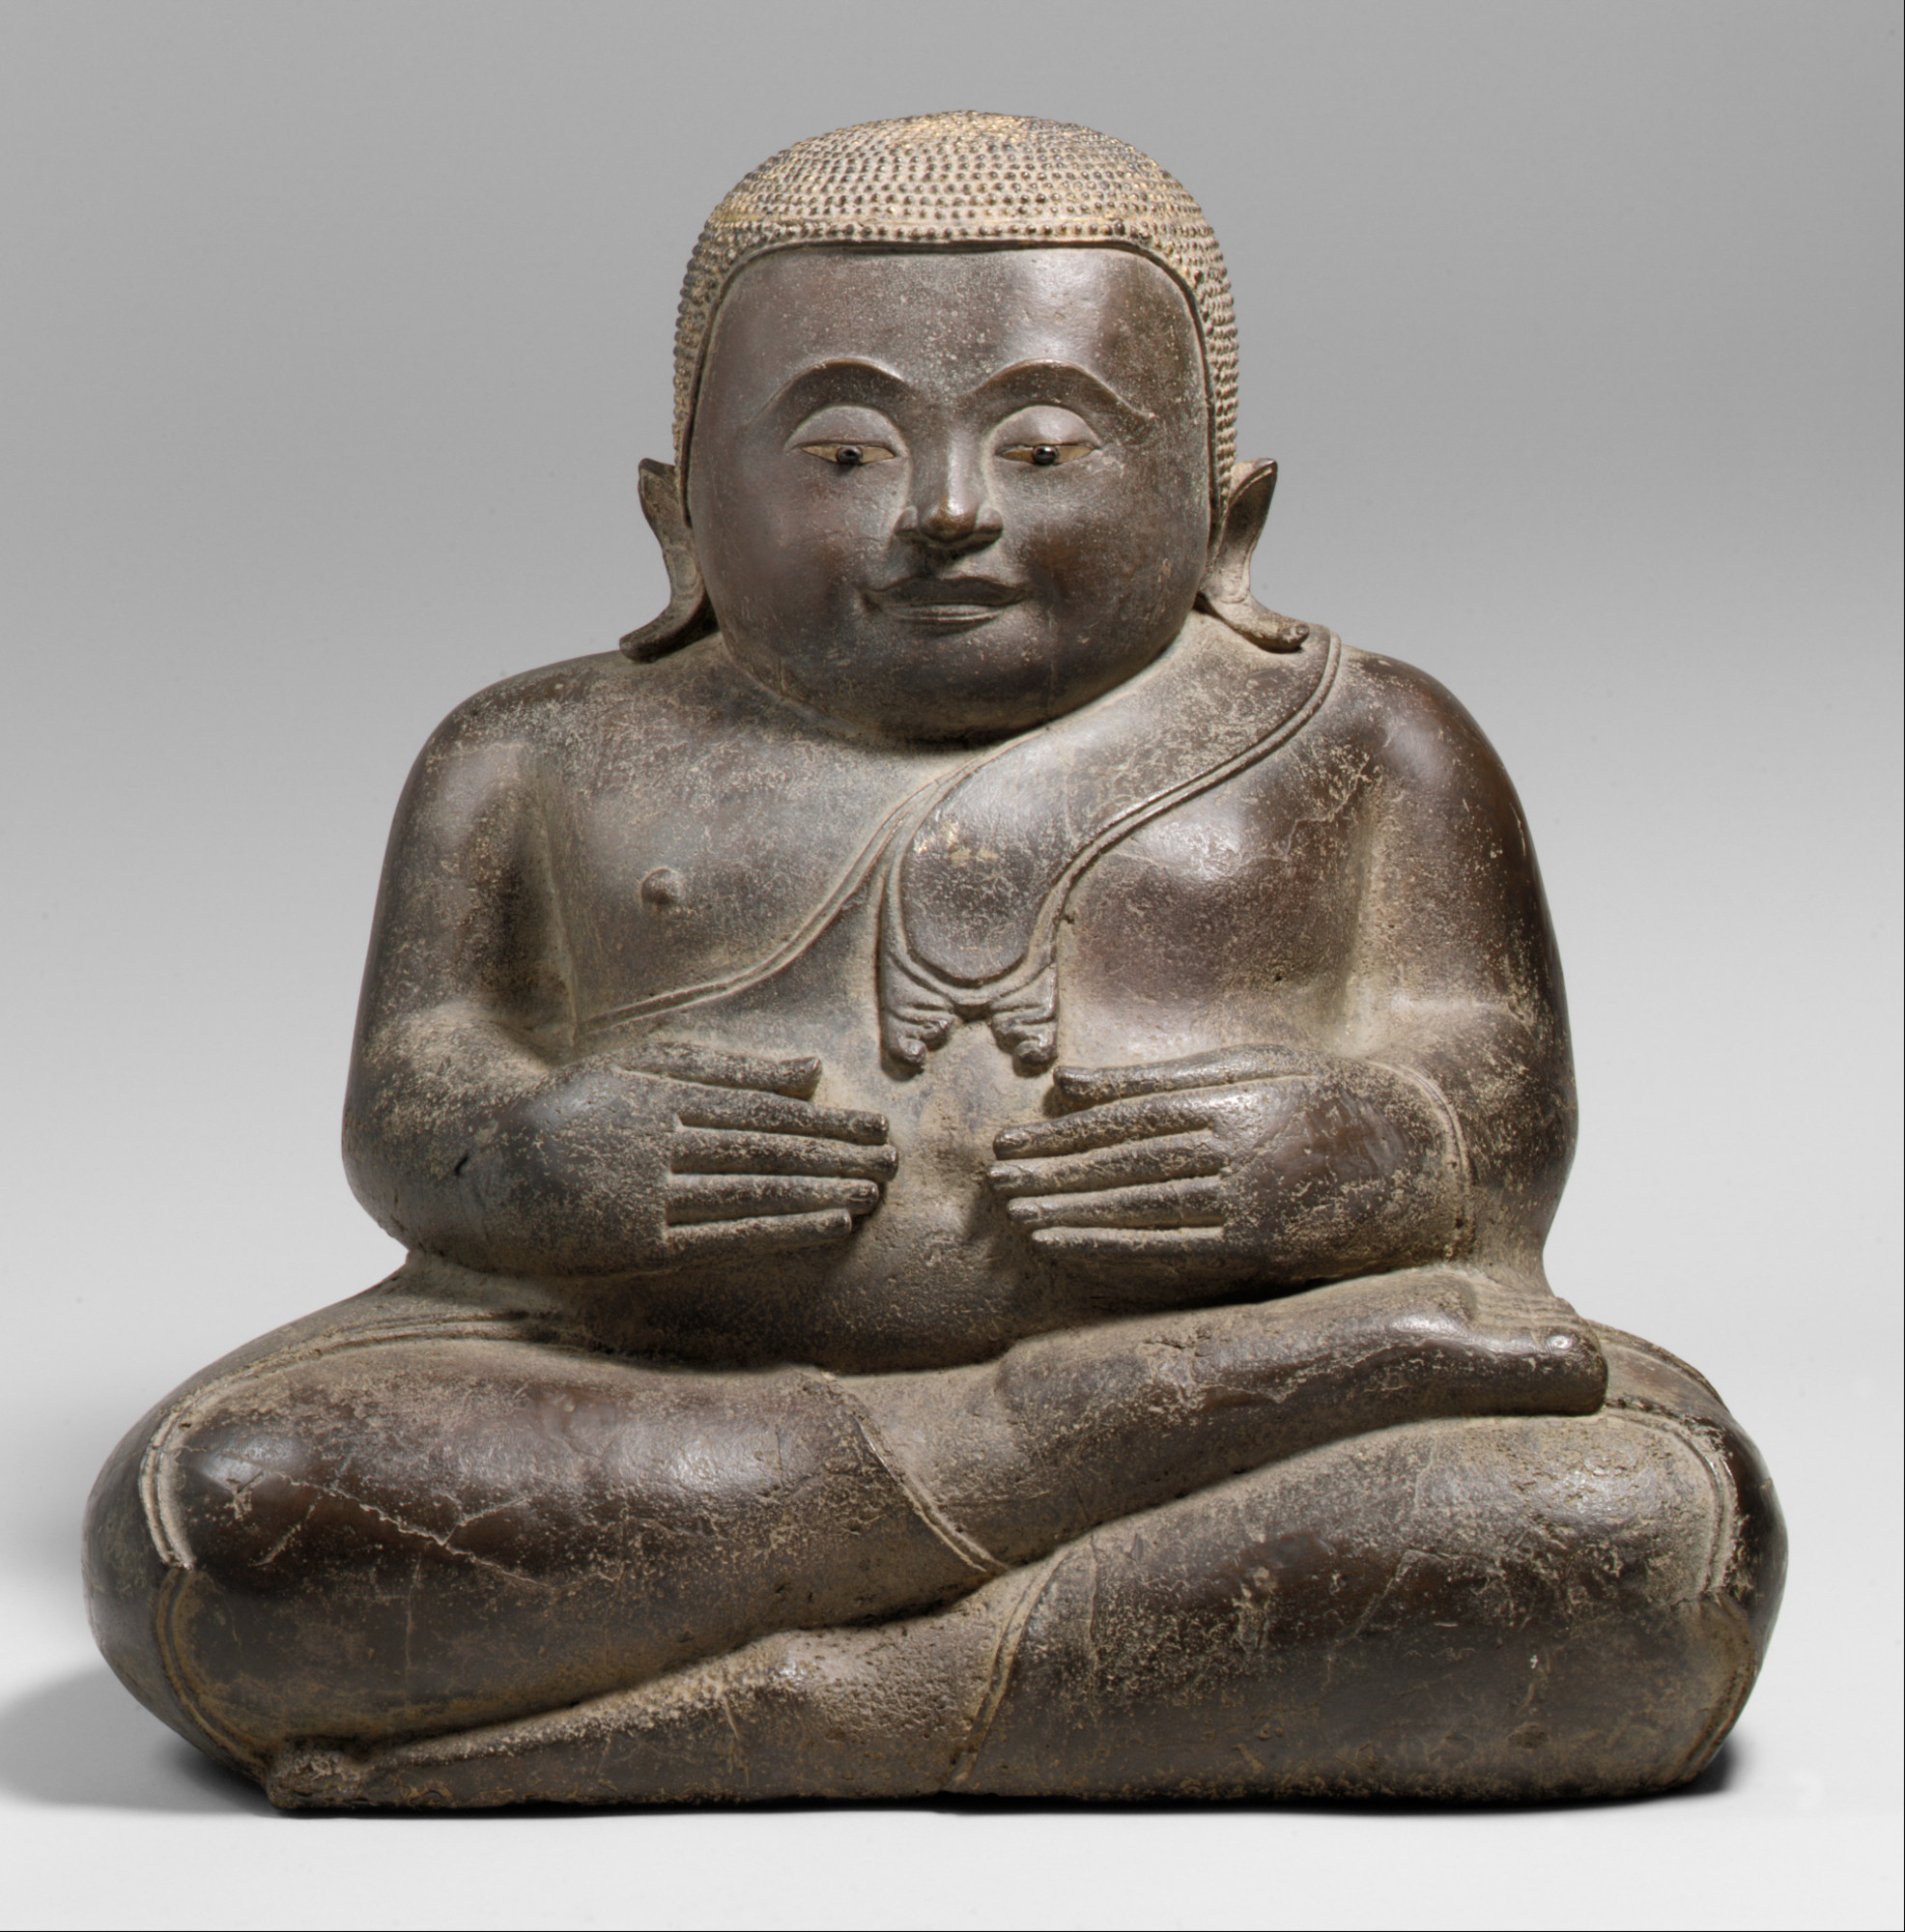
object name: figure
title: The Buddhist Disciple Phra Sankachai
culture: thai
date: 1667-1700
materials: bronze, gemstone, gilt, shell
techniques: inlay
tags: men